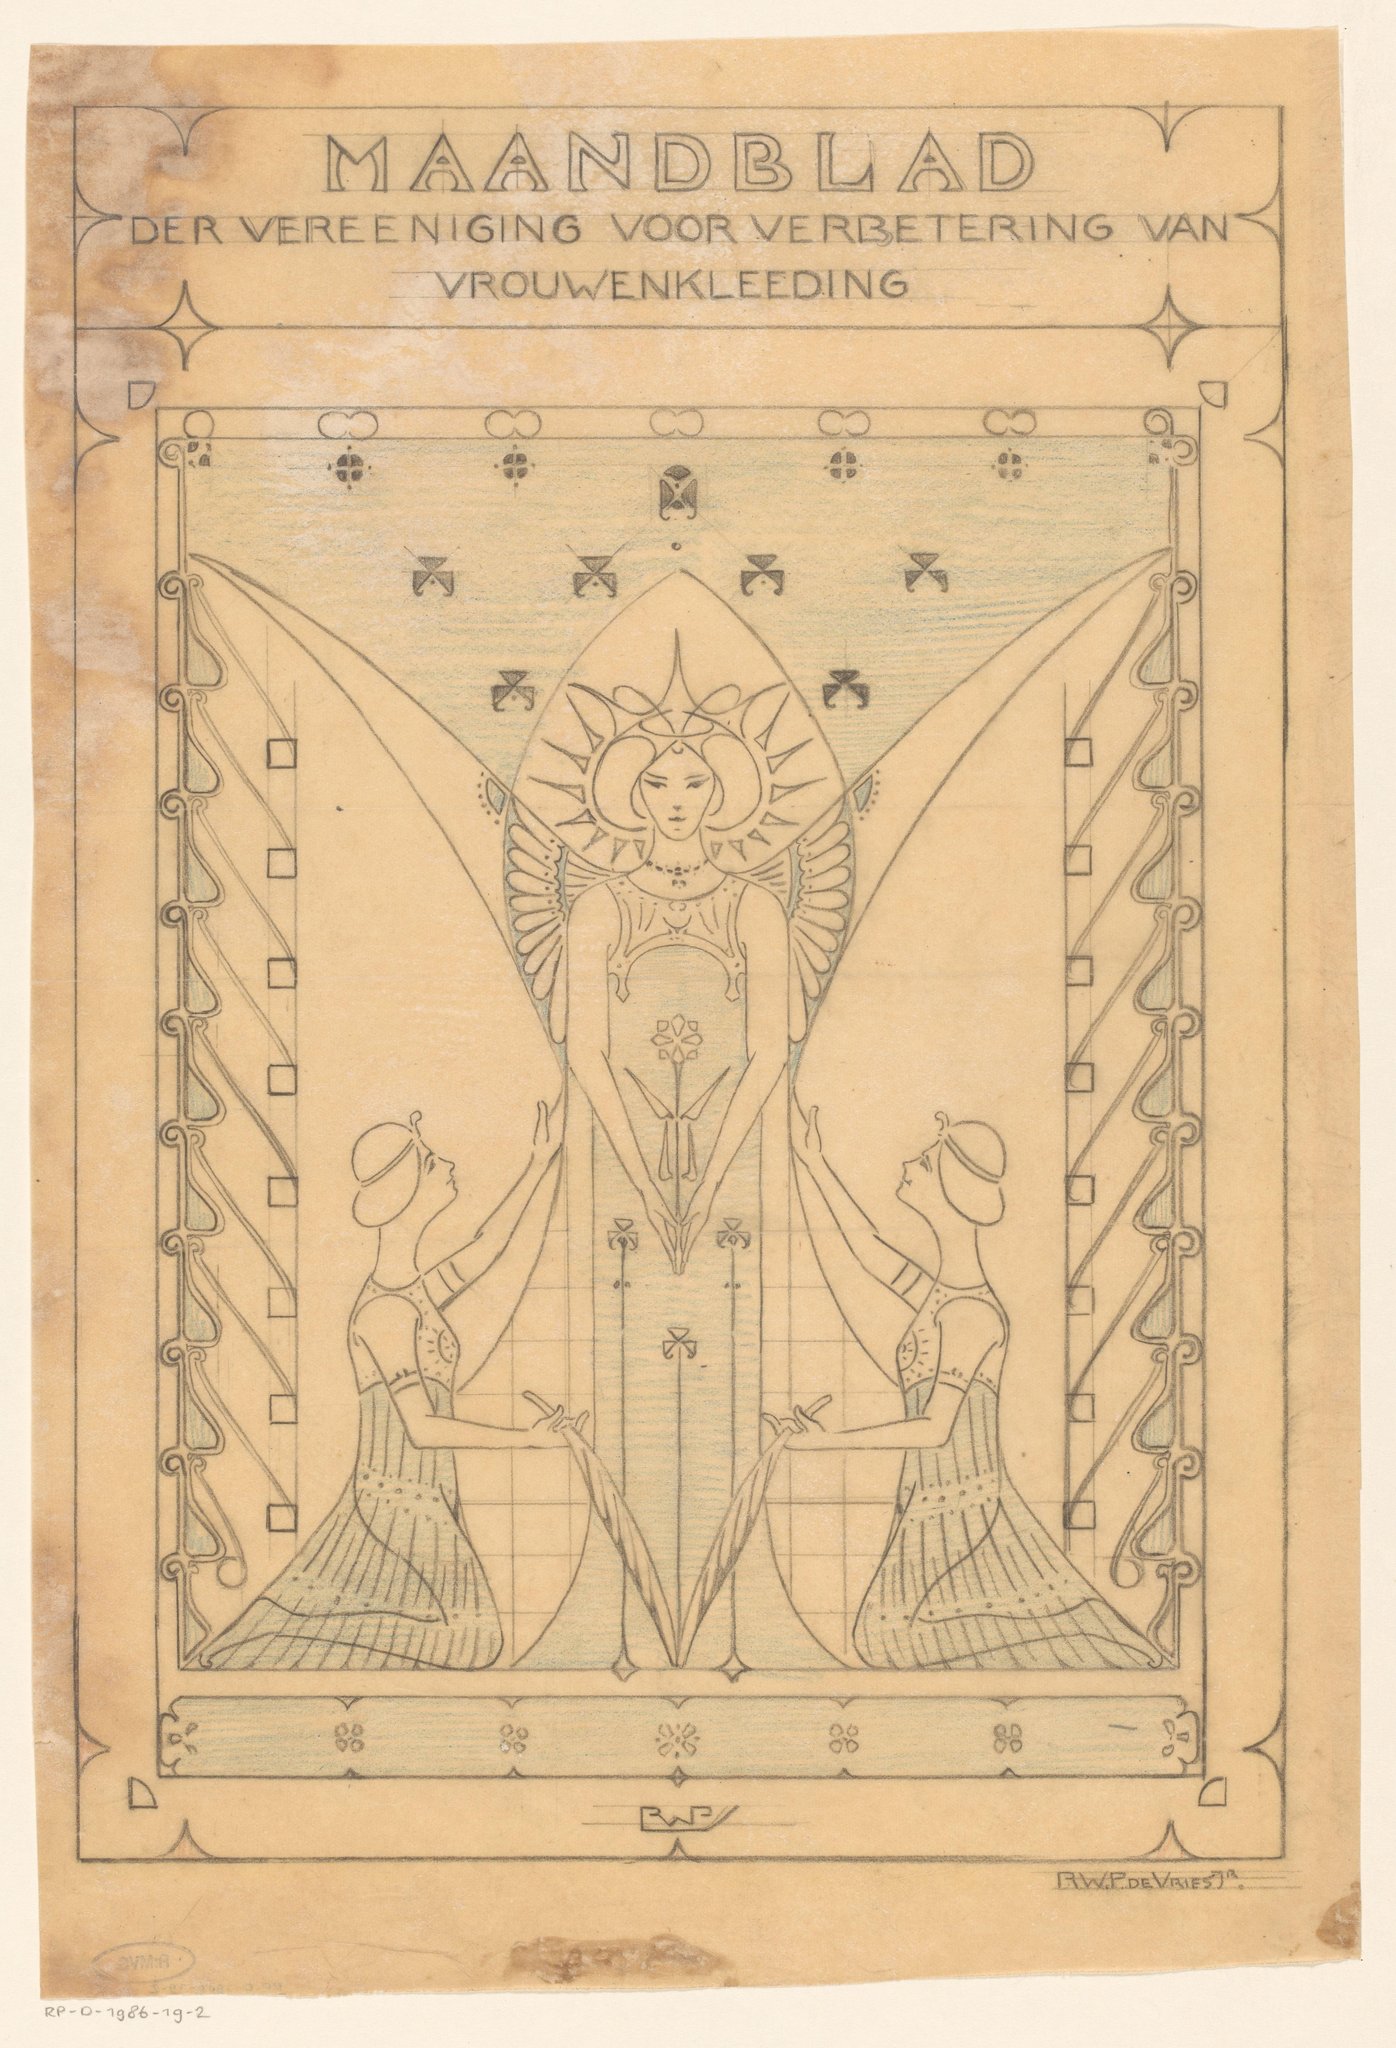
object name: design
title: Omslagontwerp voor: Maandblad der Vereeniging voor verbetering van vrouwenkleeding, 1901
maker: reinier willem petrus de vries (1874-1953)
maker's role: draughtsman, print maker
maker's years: 1874-1953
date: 1901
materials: pencil, paper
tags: ornaments ~ art, kneeling figure - aa - female human figure, standing figure - aa - female human figure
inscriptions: collector's mark: ‘R:MVS.’, monogram: ‘RWP’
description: Staande gevleugelde vrouw in een lange japon met een krans van lichtstralen om haar hoofd. Naast de vrouw knielen twee meisjes. Zij dragen een palmtak in de ene hand en reiken met de andere hand omhoog naar de staande vrouw. De voorstelling is omsloten door een geornamenteerd rechthoekig kader.